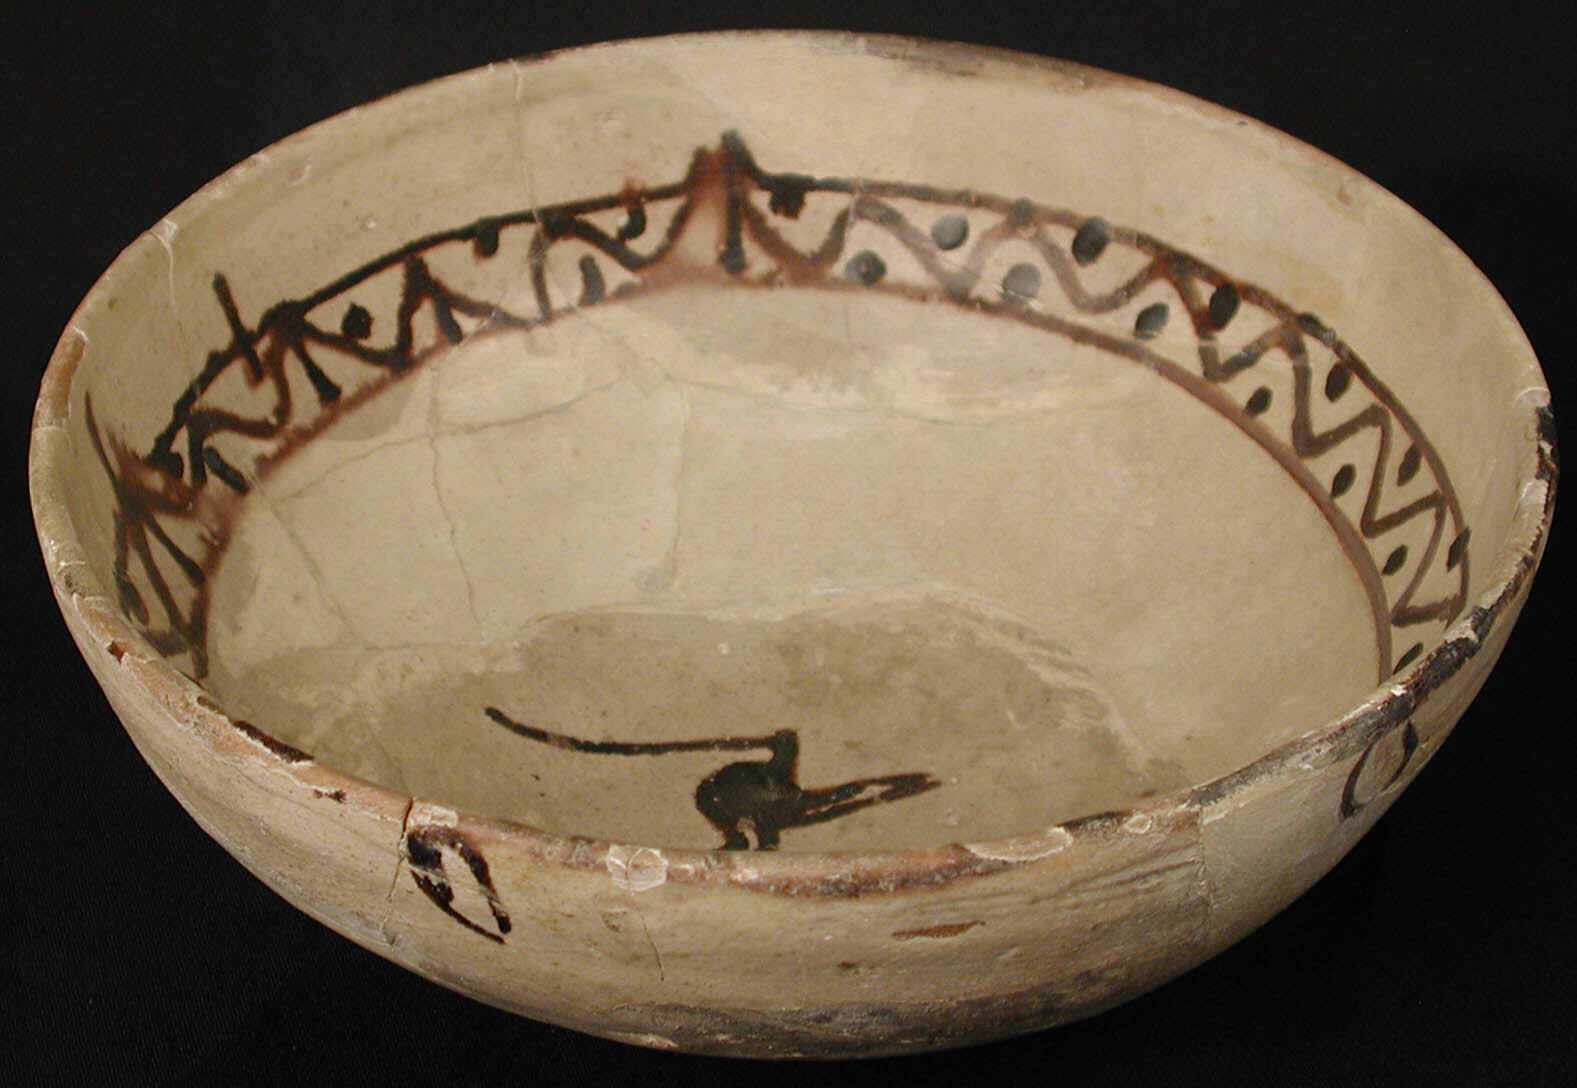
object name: bowl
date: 801-1000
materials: earthenware, glaze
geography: iran